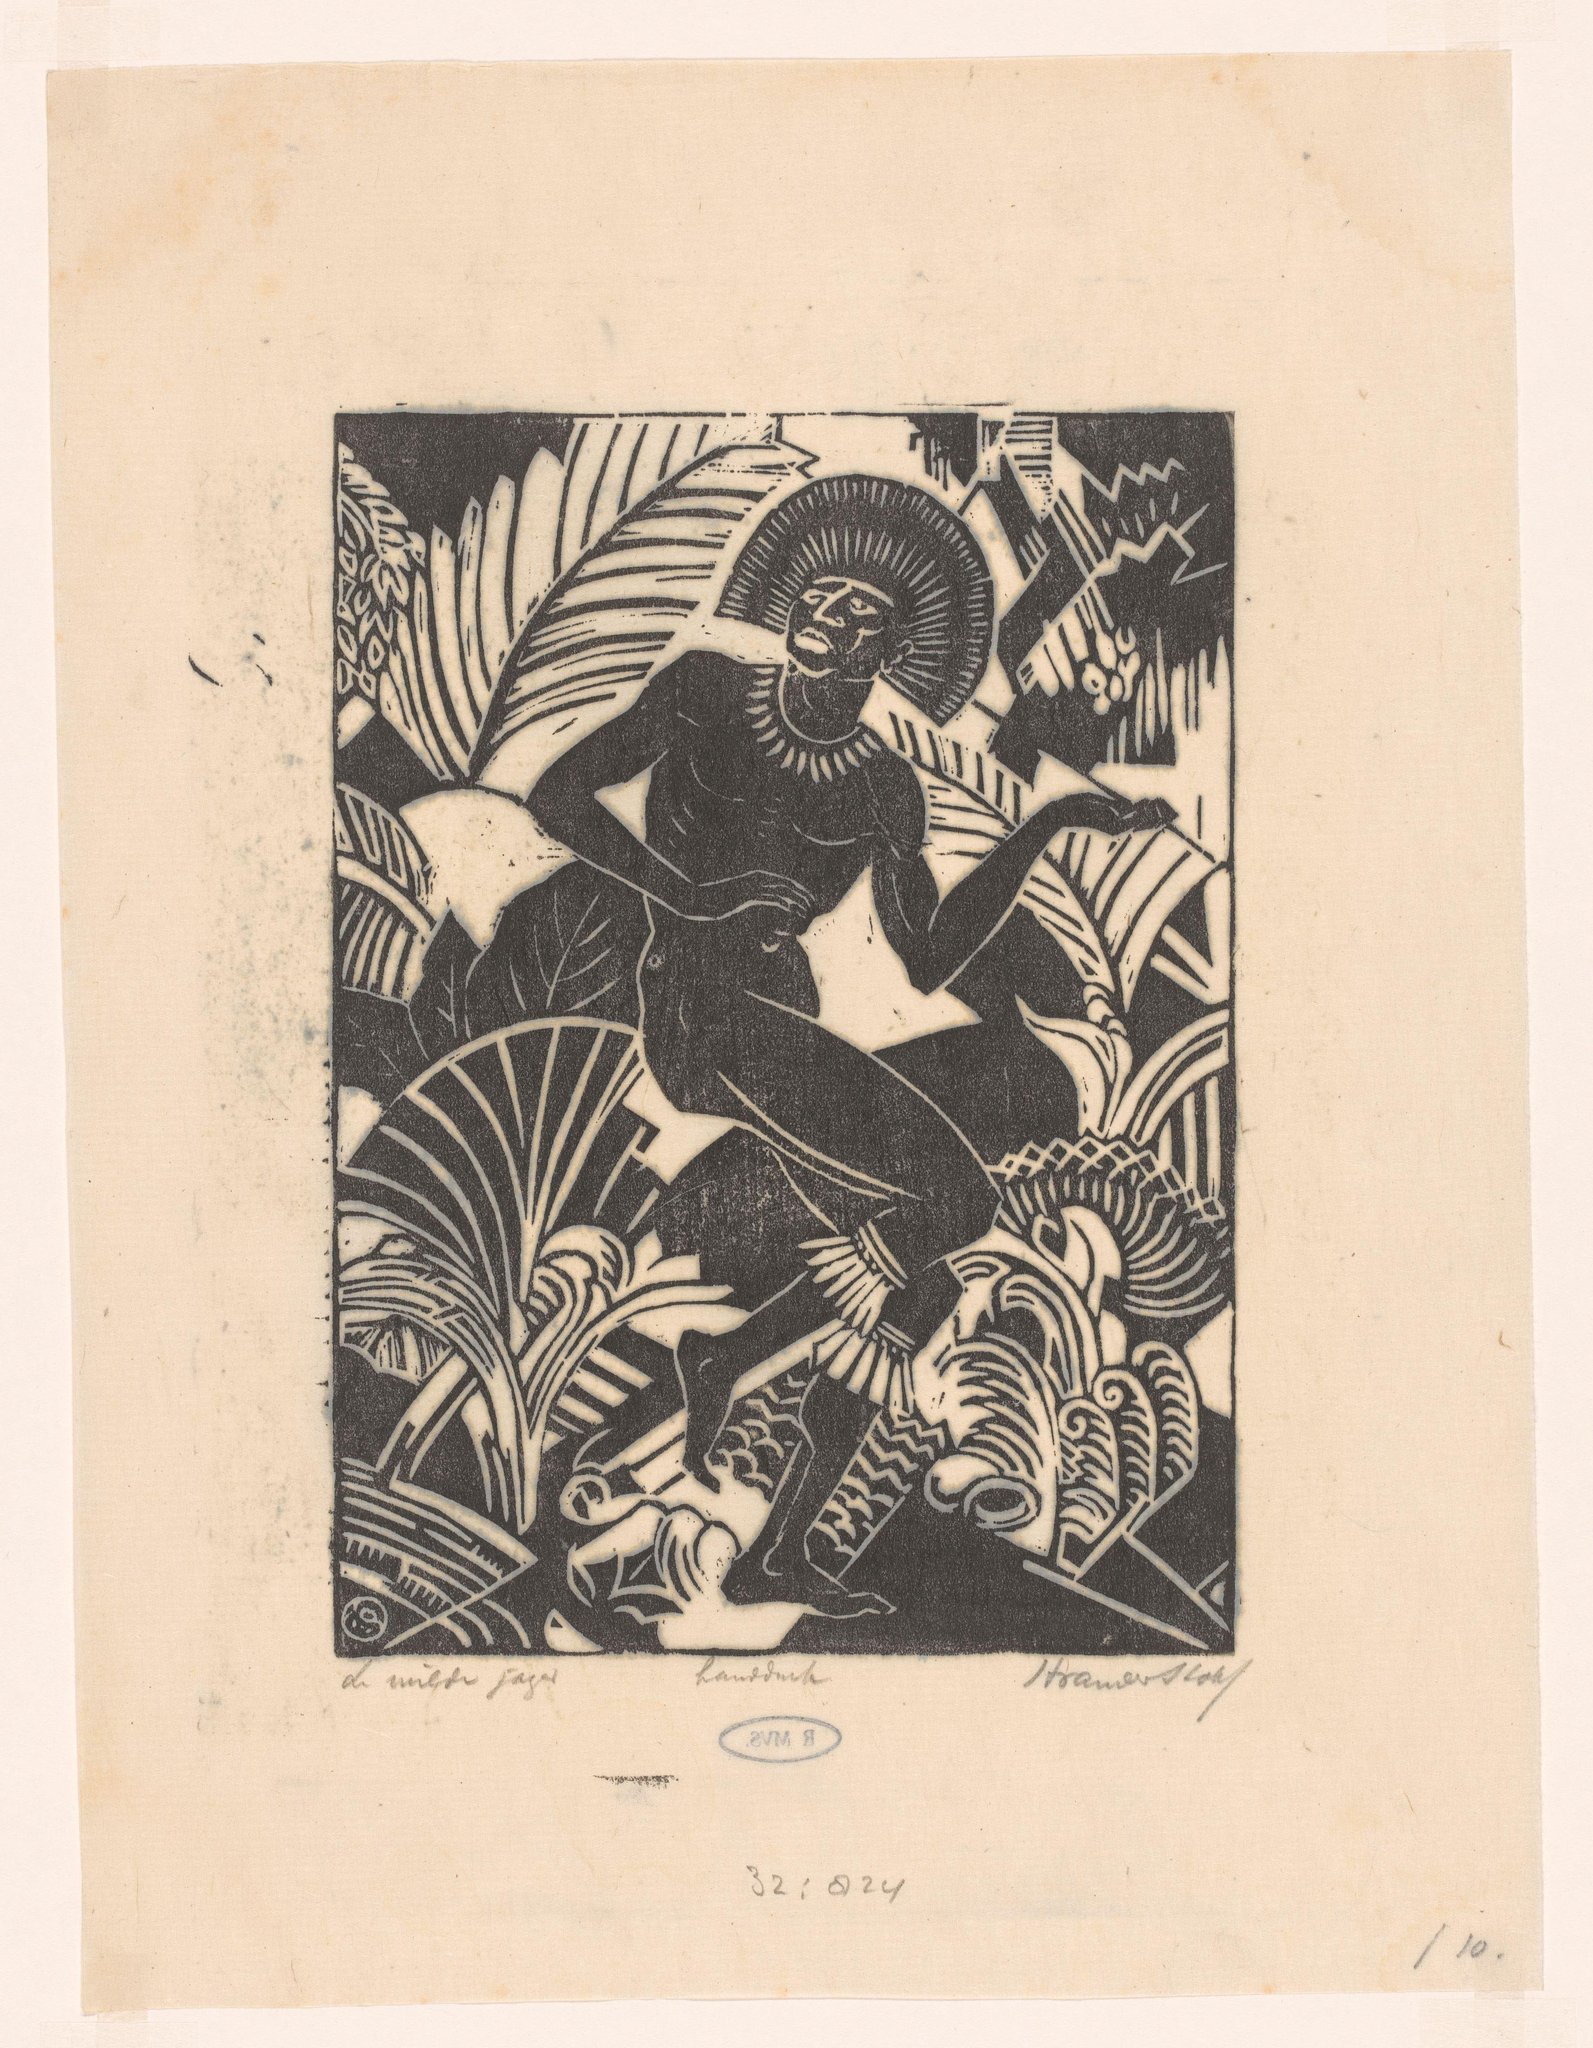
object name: print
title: Jager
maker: henri van der stok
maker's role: print maker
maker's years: 1870-1946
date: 1880-1932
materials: paper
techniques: woodcut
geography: netherlands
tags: africans, hunter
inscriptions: collector's mark: Lugt 2228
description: Een zwarte man met kroon op het hoofd staat gedraaid op één been tussen struikgewas. In zijn linkerhand houdt hij een speer of een pijl.